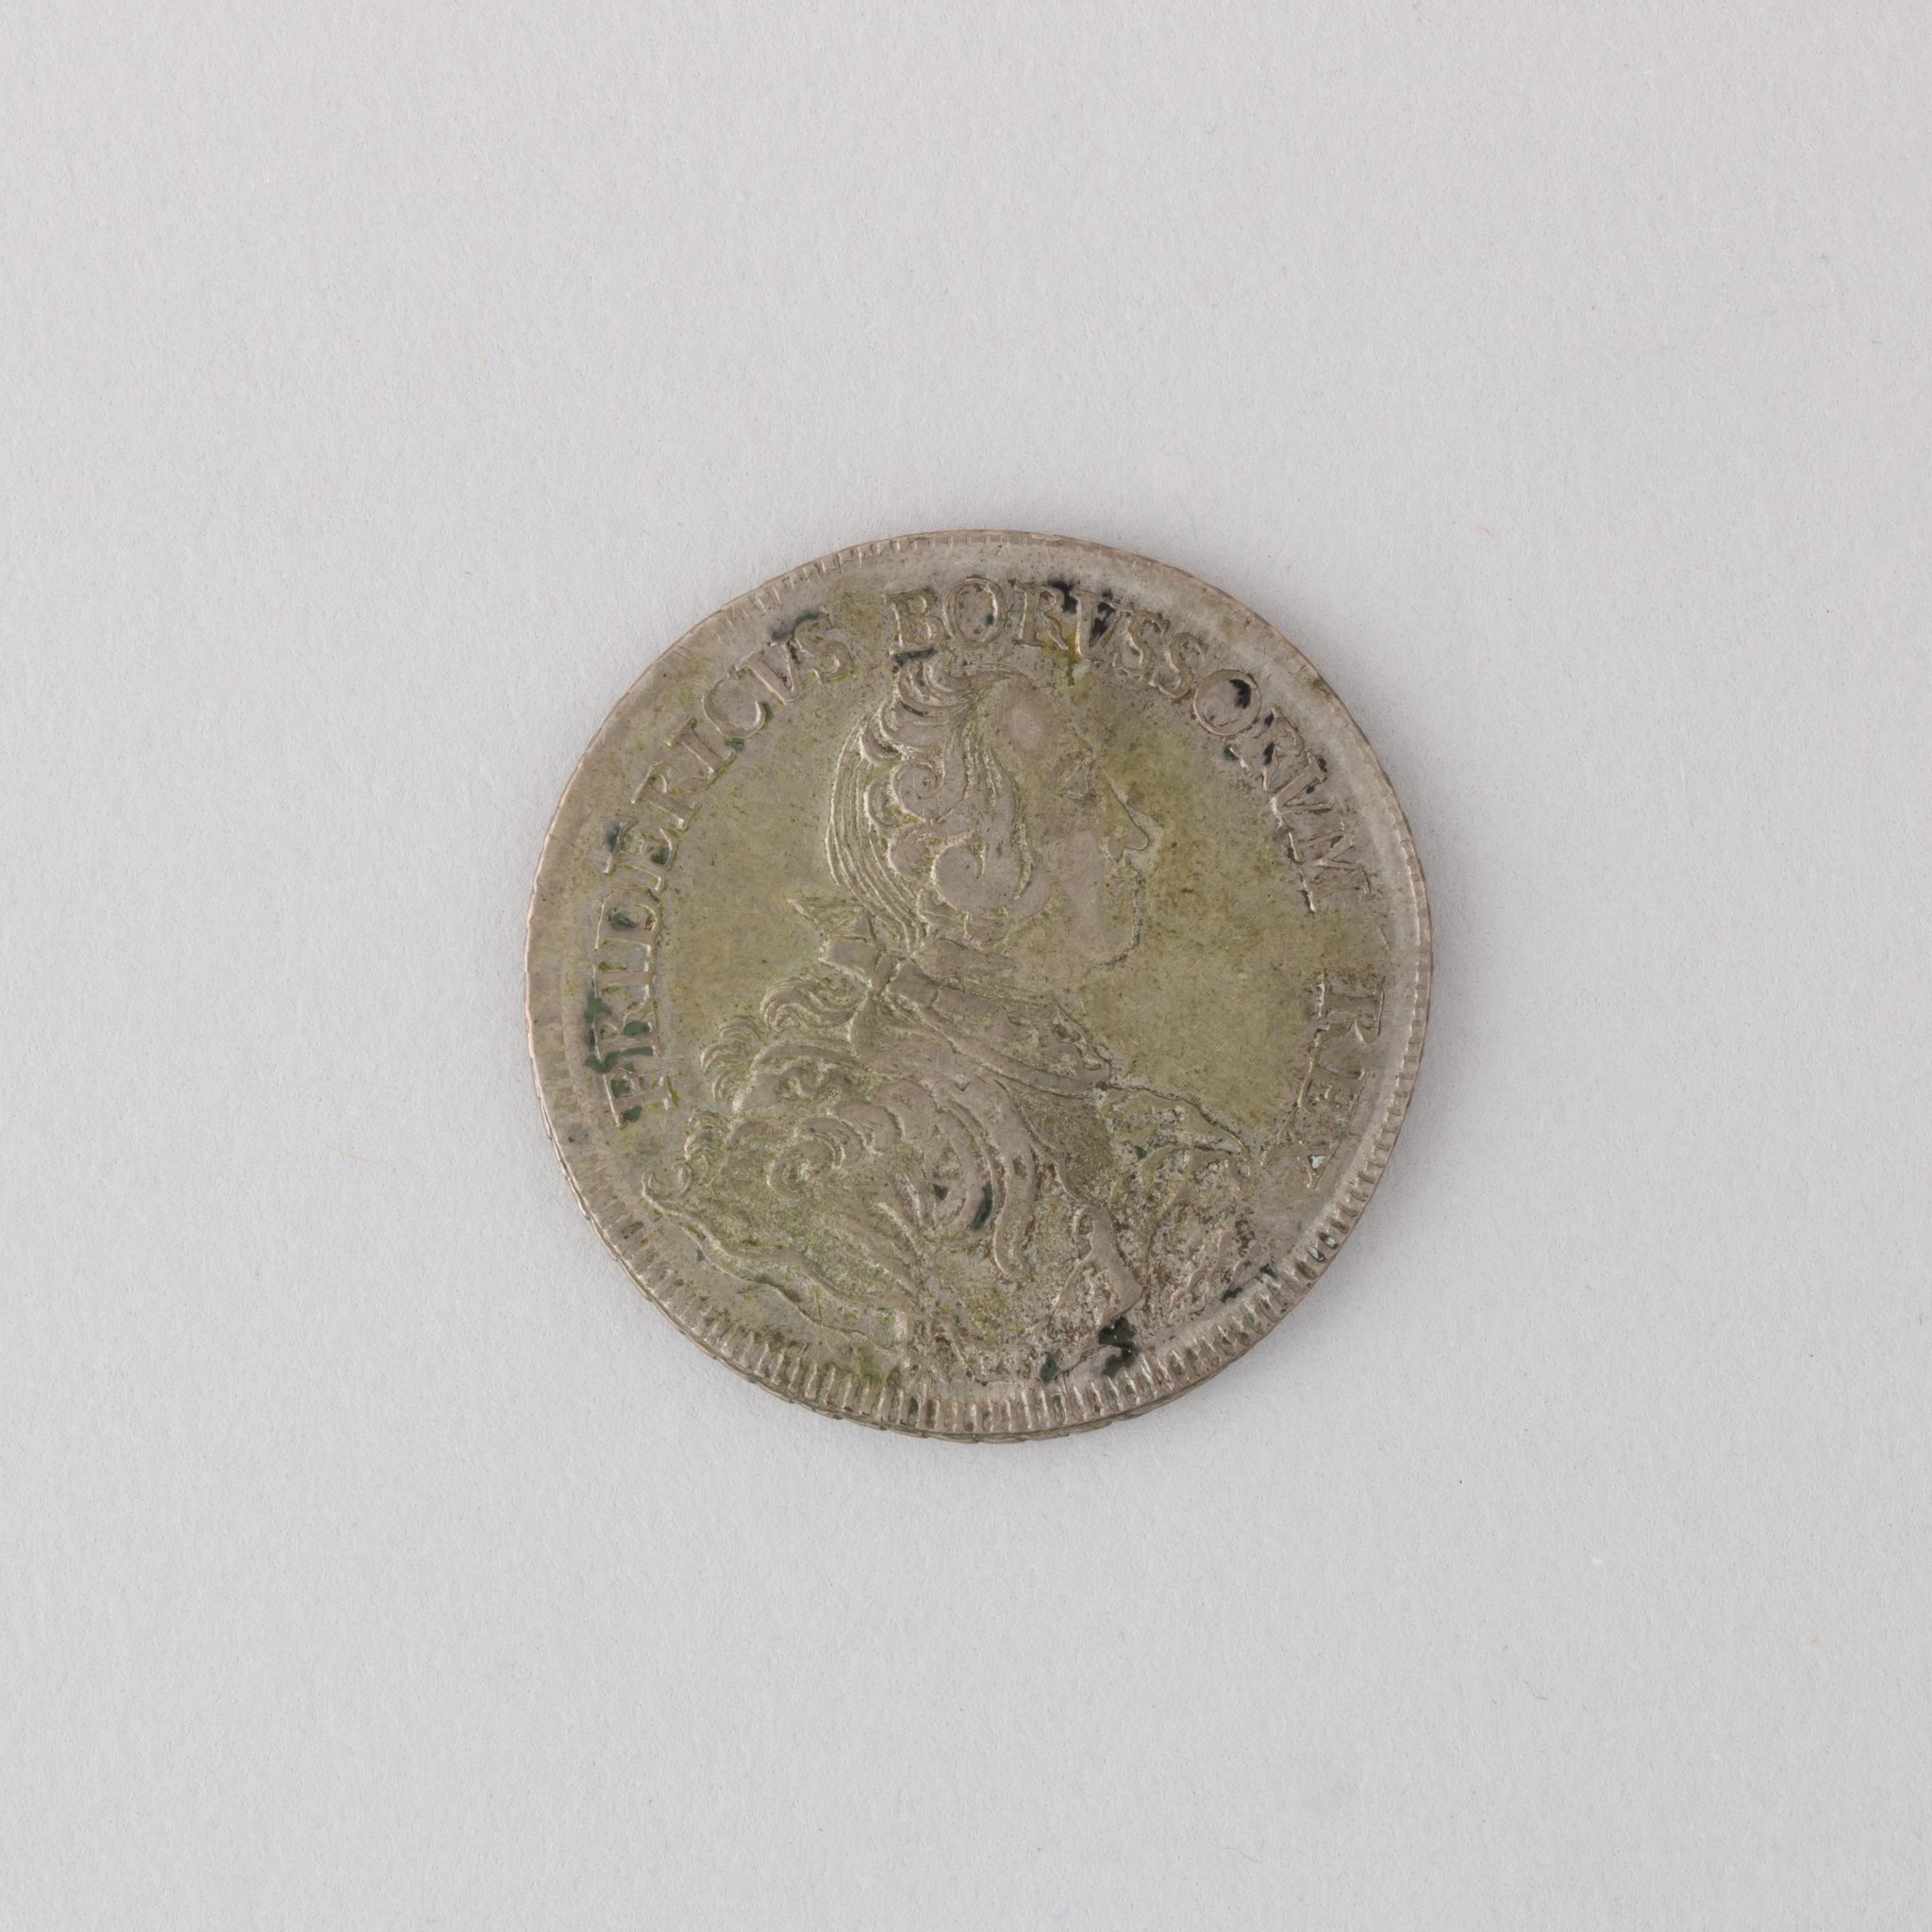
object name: coin thaler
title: Coin (Thaler) Showing Frederick the Great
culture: german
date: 1751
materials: silver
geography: germany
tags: men,profiles,coins